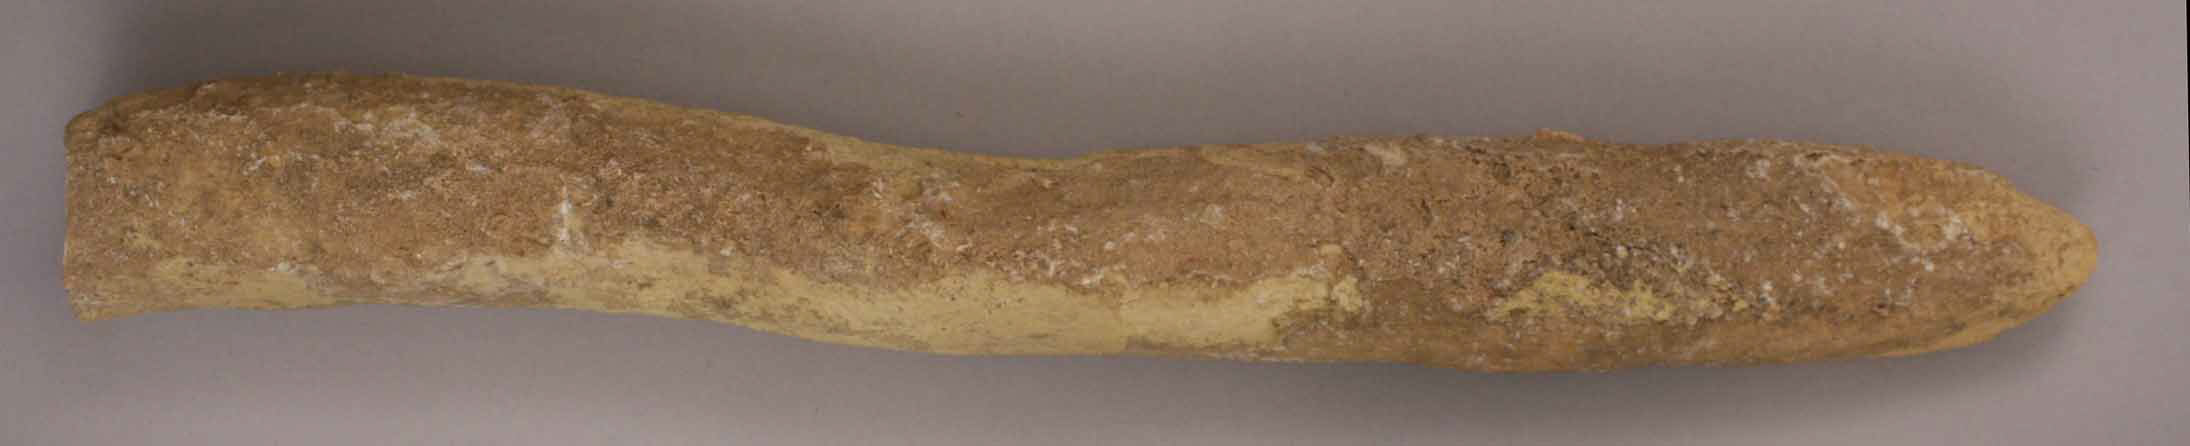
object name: kiln rod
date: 801-900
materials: earthenware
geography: iraq